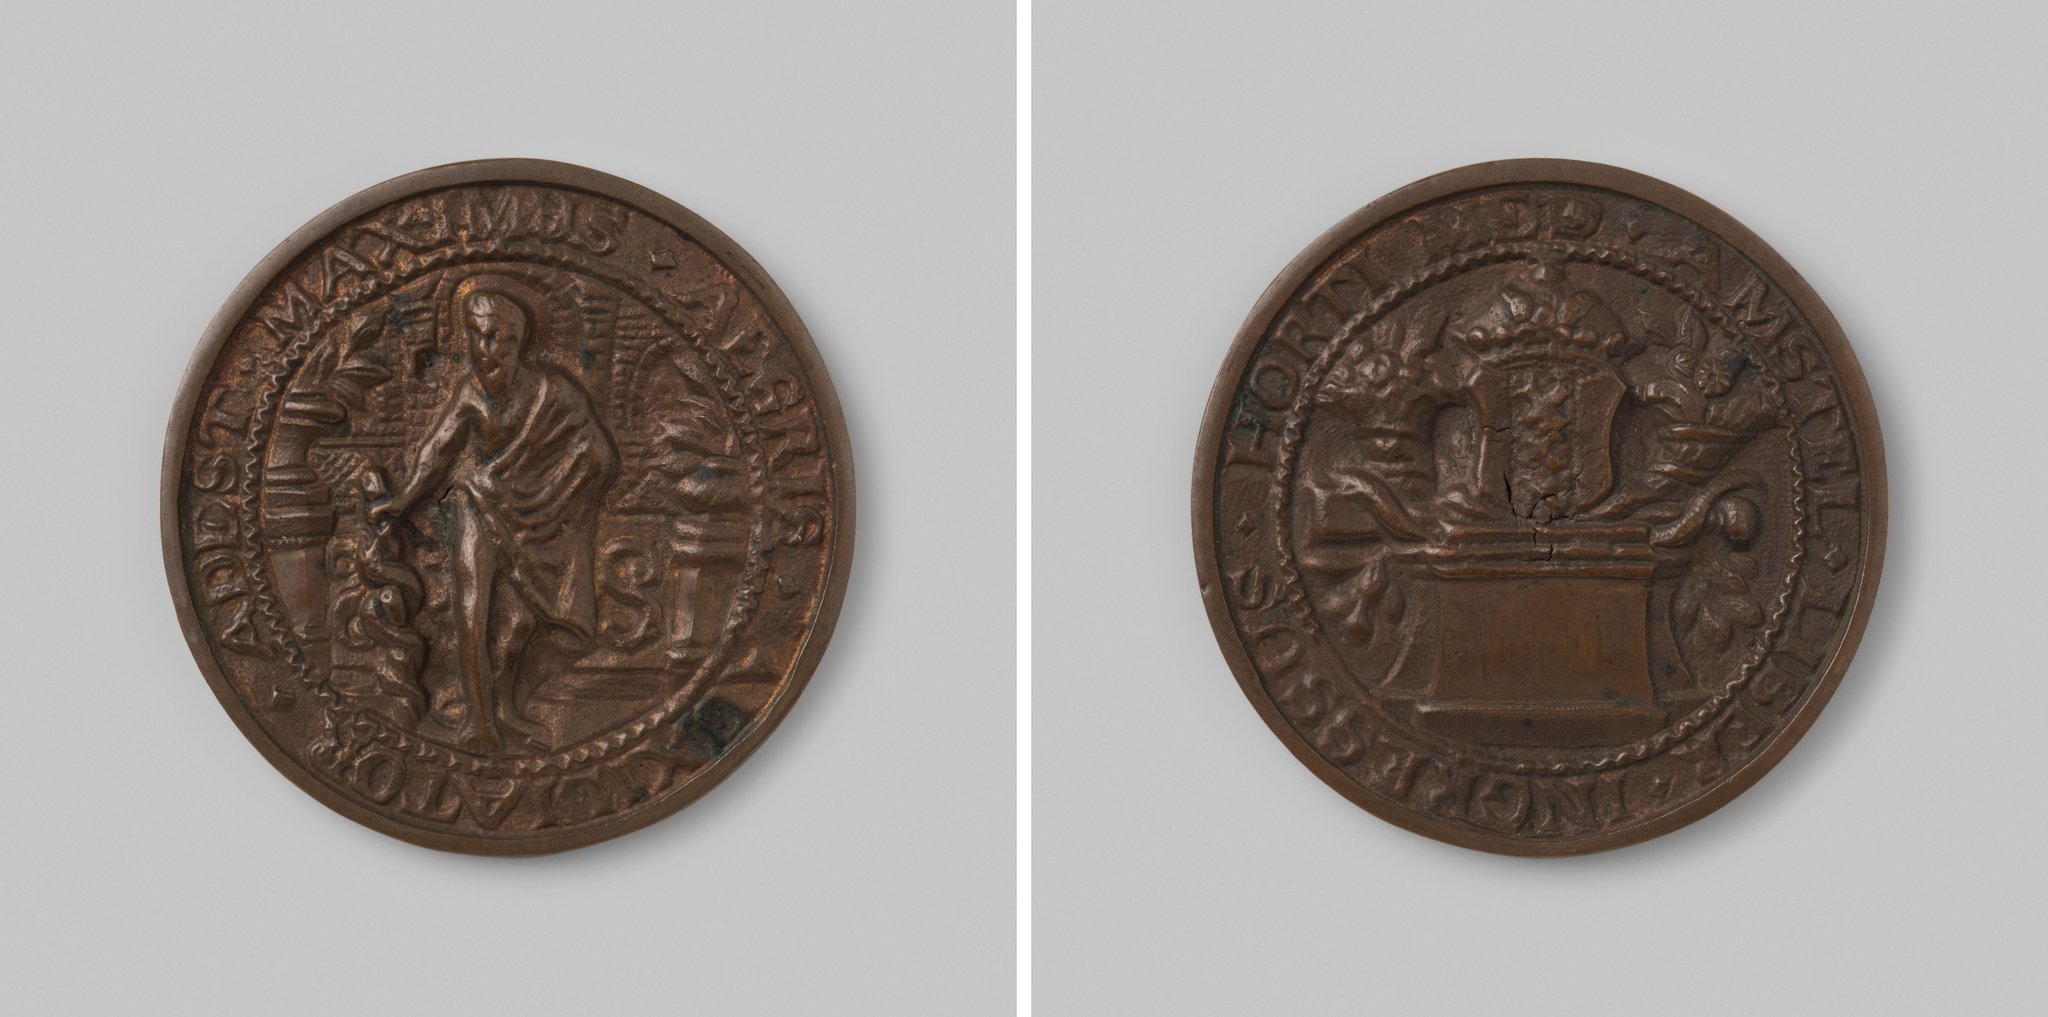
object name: history medal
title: Toegangspenning tot de Hortus Medicus te Amsterdam 1696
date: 1696-1699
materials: copper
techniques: casting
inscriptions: circumscription: ‘MAXIMUS AEGRIS AUXILIATOR ADEST’, circumscription: ‘HORTI MED AMSTEL LIBER INGRESSUS’, inscription: ‘H’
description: Gegoten koperen penning met op de voorzijde Aesculapius en op de keerzijde een altaar waarop het gekroonde stadswapen, een caduceus en cornucopiae waaruit kruidentakken, zonder inscriptie